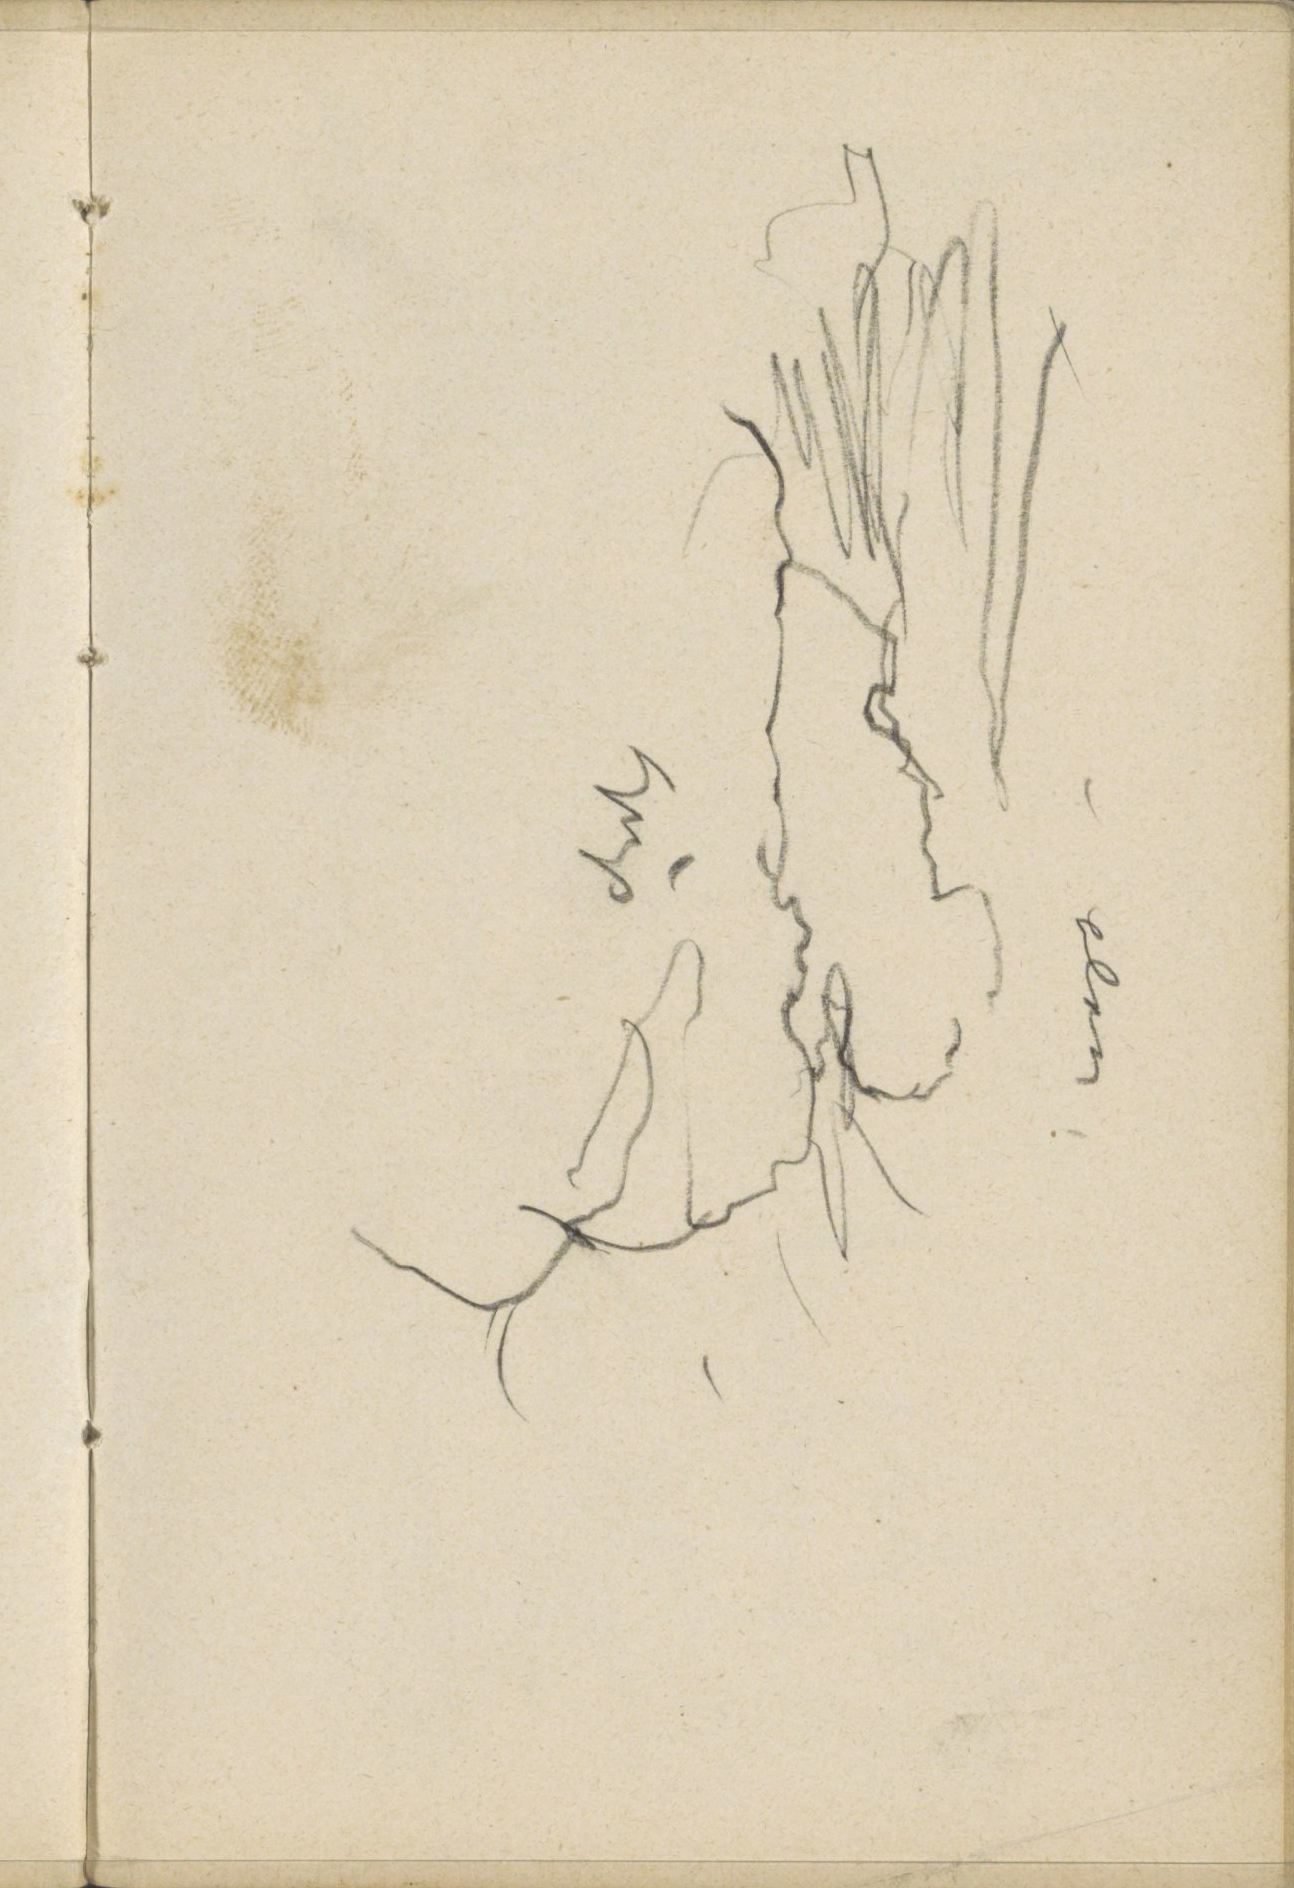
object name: sketchbook leaf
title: Studie, mogelijk van een wolkenlucht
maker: george hendrik breitner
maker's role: draughtsman, painter, print maker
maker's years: 1857-1923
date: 1902-1914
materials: chalk, paper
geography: amsterdam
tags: clouds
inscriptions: kleurnotitie, handgeschreven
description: Studie, mogelijk van een wolkenlucht. Pagina 56 uit een schetsboek met 46 bladen vervaardigd te Noord-Holland en Utrecht.